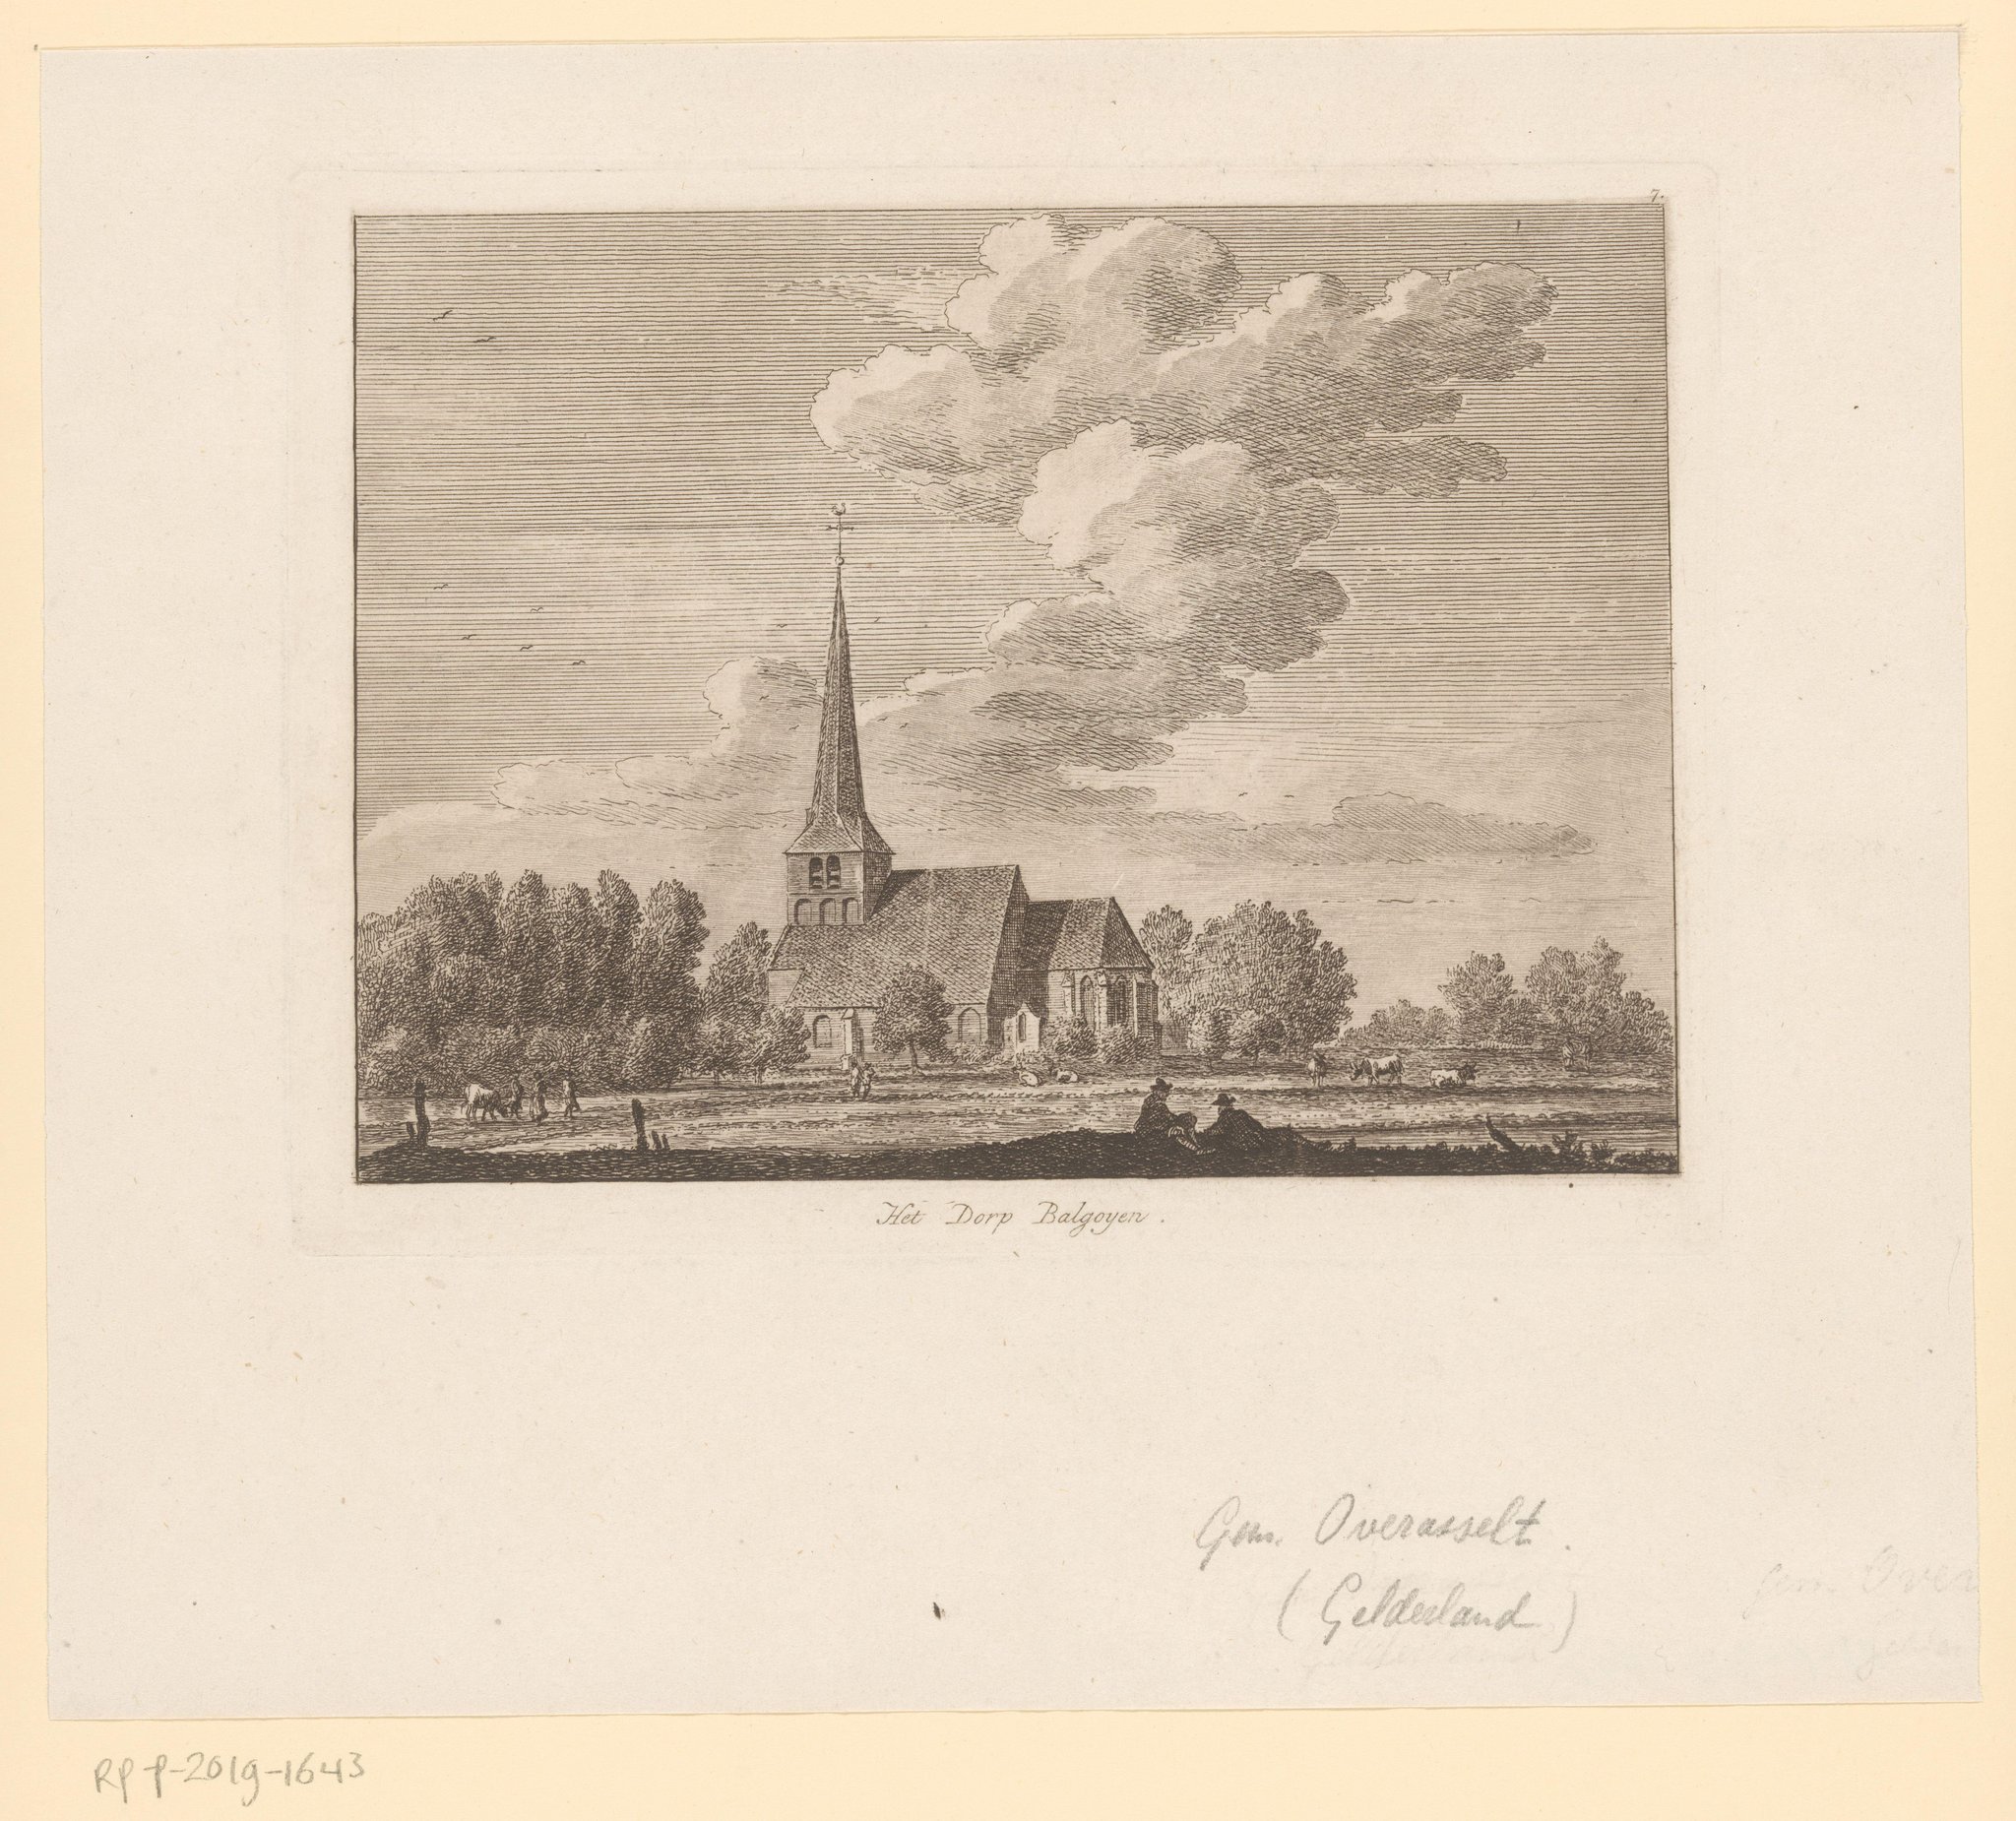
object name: print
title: Nederlandse dorpsgezichten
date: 1770-1800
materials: paper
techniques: etching, intaglio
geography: amsterdam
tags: church (exterior), village (+ city(-scape) with figures, staffage)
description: Prent mogelijk uit: Gezichten voorname Hollandse dorpen. Amsterdam: Pierre Fouquet, s.a.